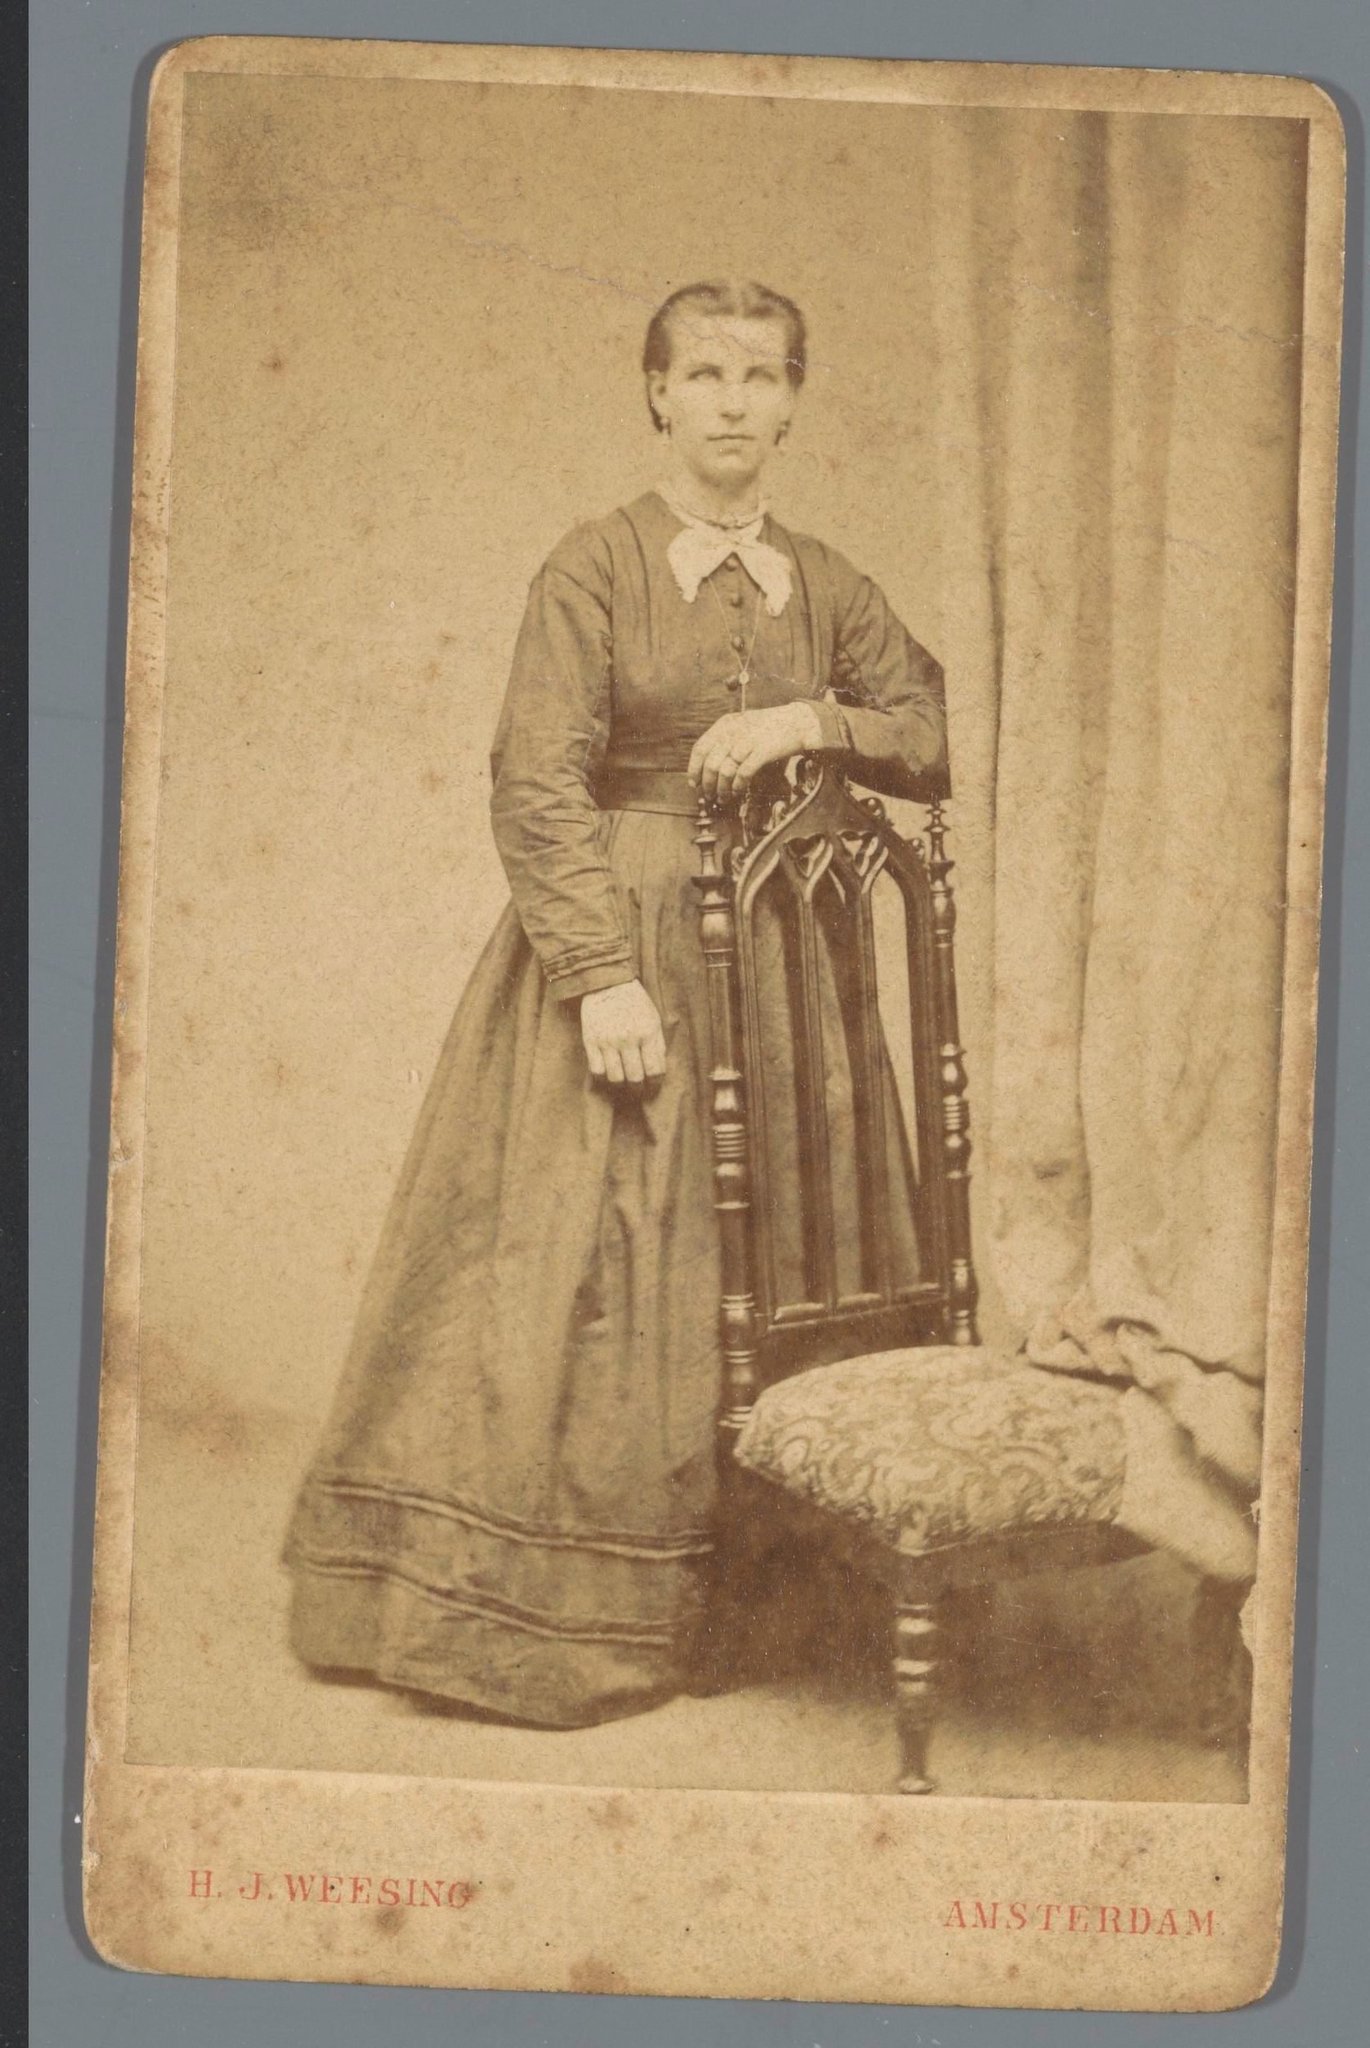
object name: photograph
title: Portret van een onbekende vrouw bij een stoel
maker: hermanus jodocus weesing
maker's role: fotograaf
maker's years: 1844-1910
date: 1868-1900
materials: cardboard, paper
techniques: albumen print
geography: amsterdam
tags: adult woman, anonymous historical person portrayed, amsterdam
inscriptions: inscription: ‘H.J. Weesing Amsterdam’, monogram: ‘HJW’, inscription: ‘H.J. Weesing/ Photograaf/ Binnen Brouwerstraat/ TT.220,/ Amsterdam.’